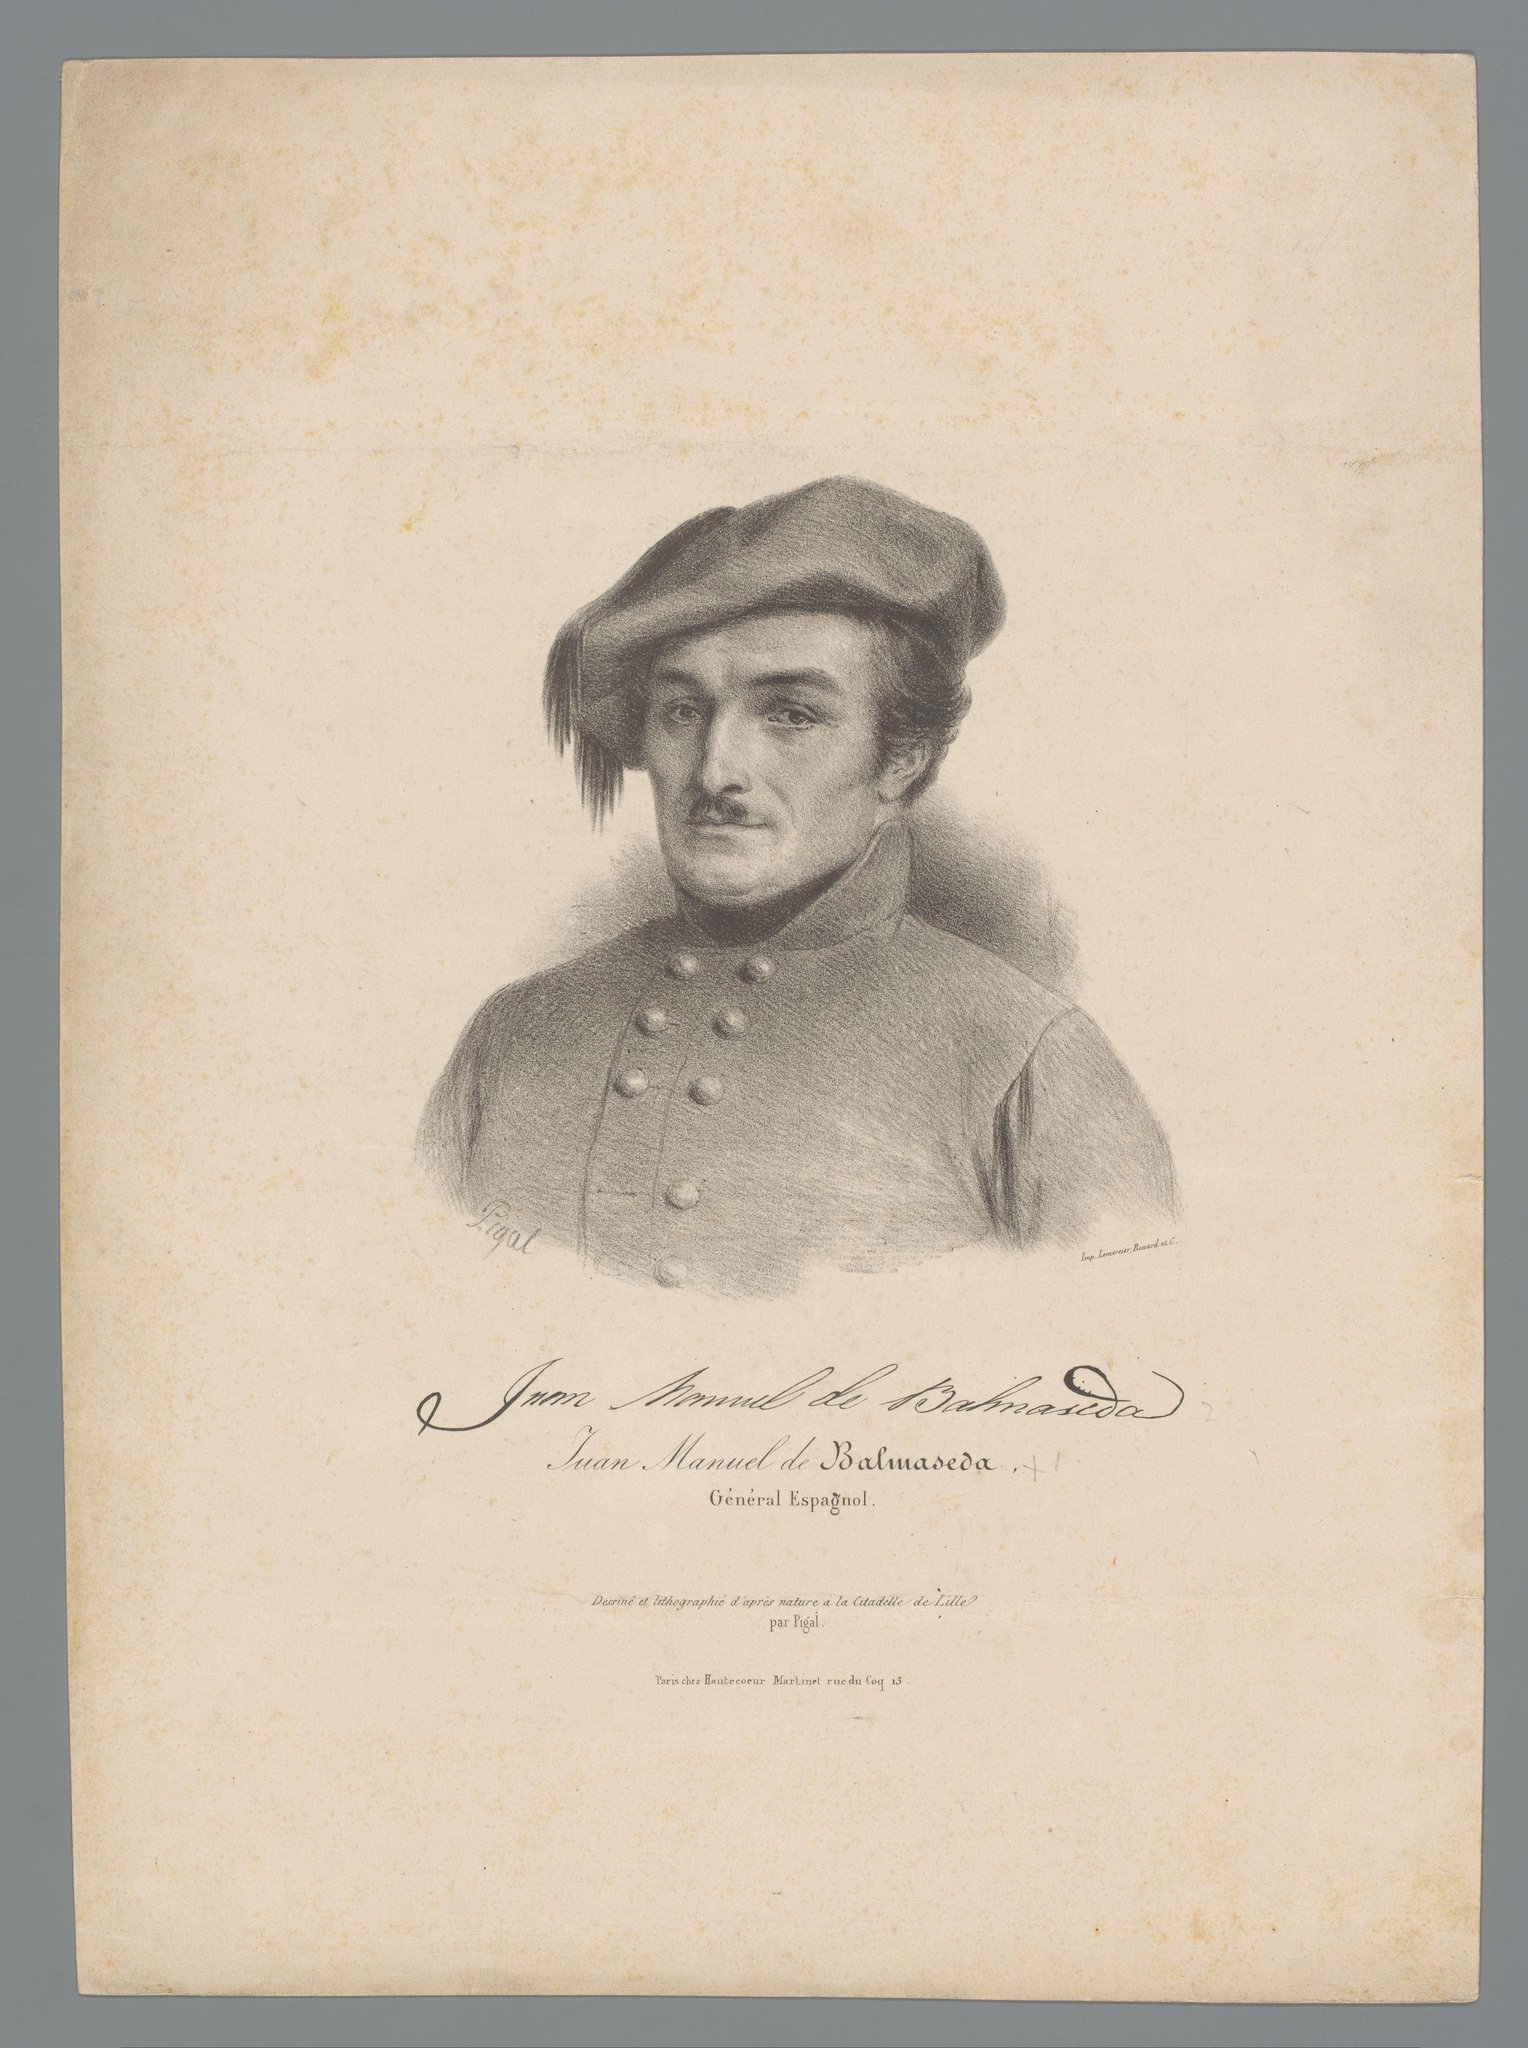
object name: print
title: Juan Manuel de Balmaseda, général espagnol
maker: edme jean pigal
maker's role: print maker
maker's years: 1798-1872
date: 1840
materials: paper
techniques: lithograph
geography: paris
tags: historical persons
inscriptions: collector's mark: Lugt 2228